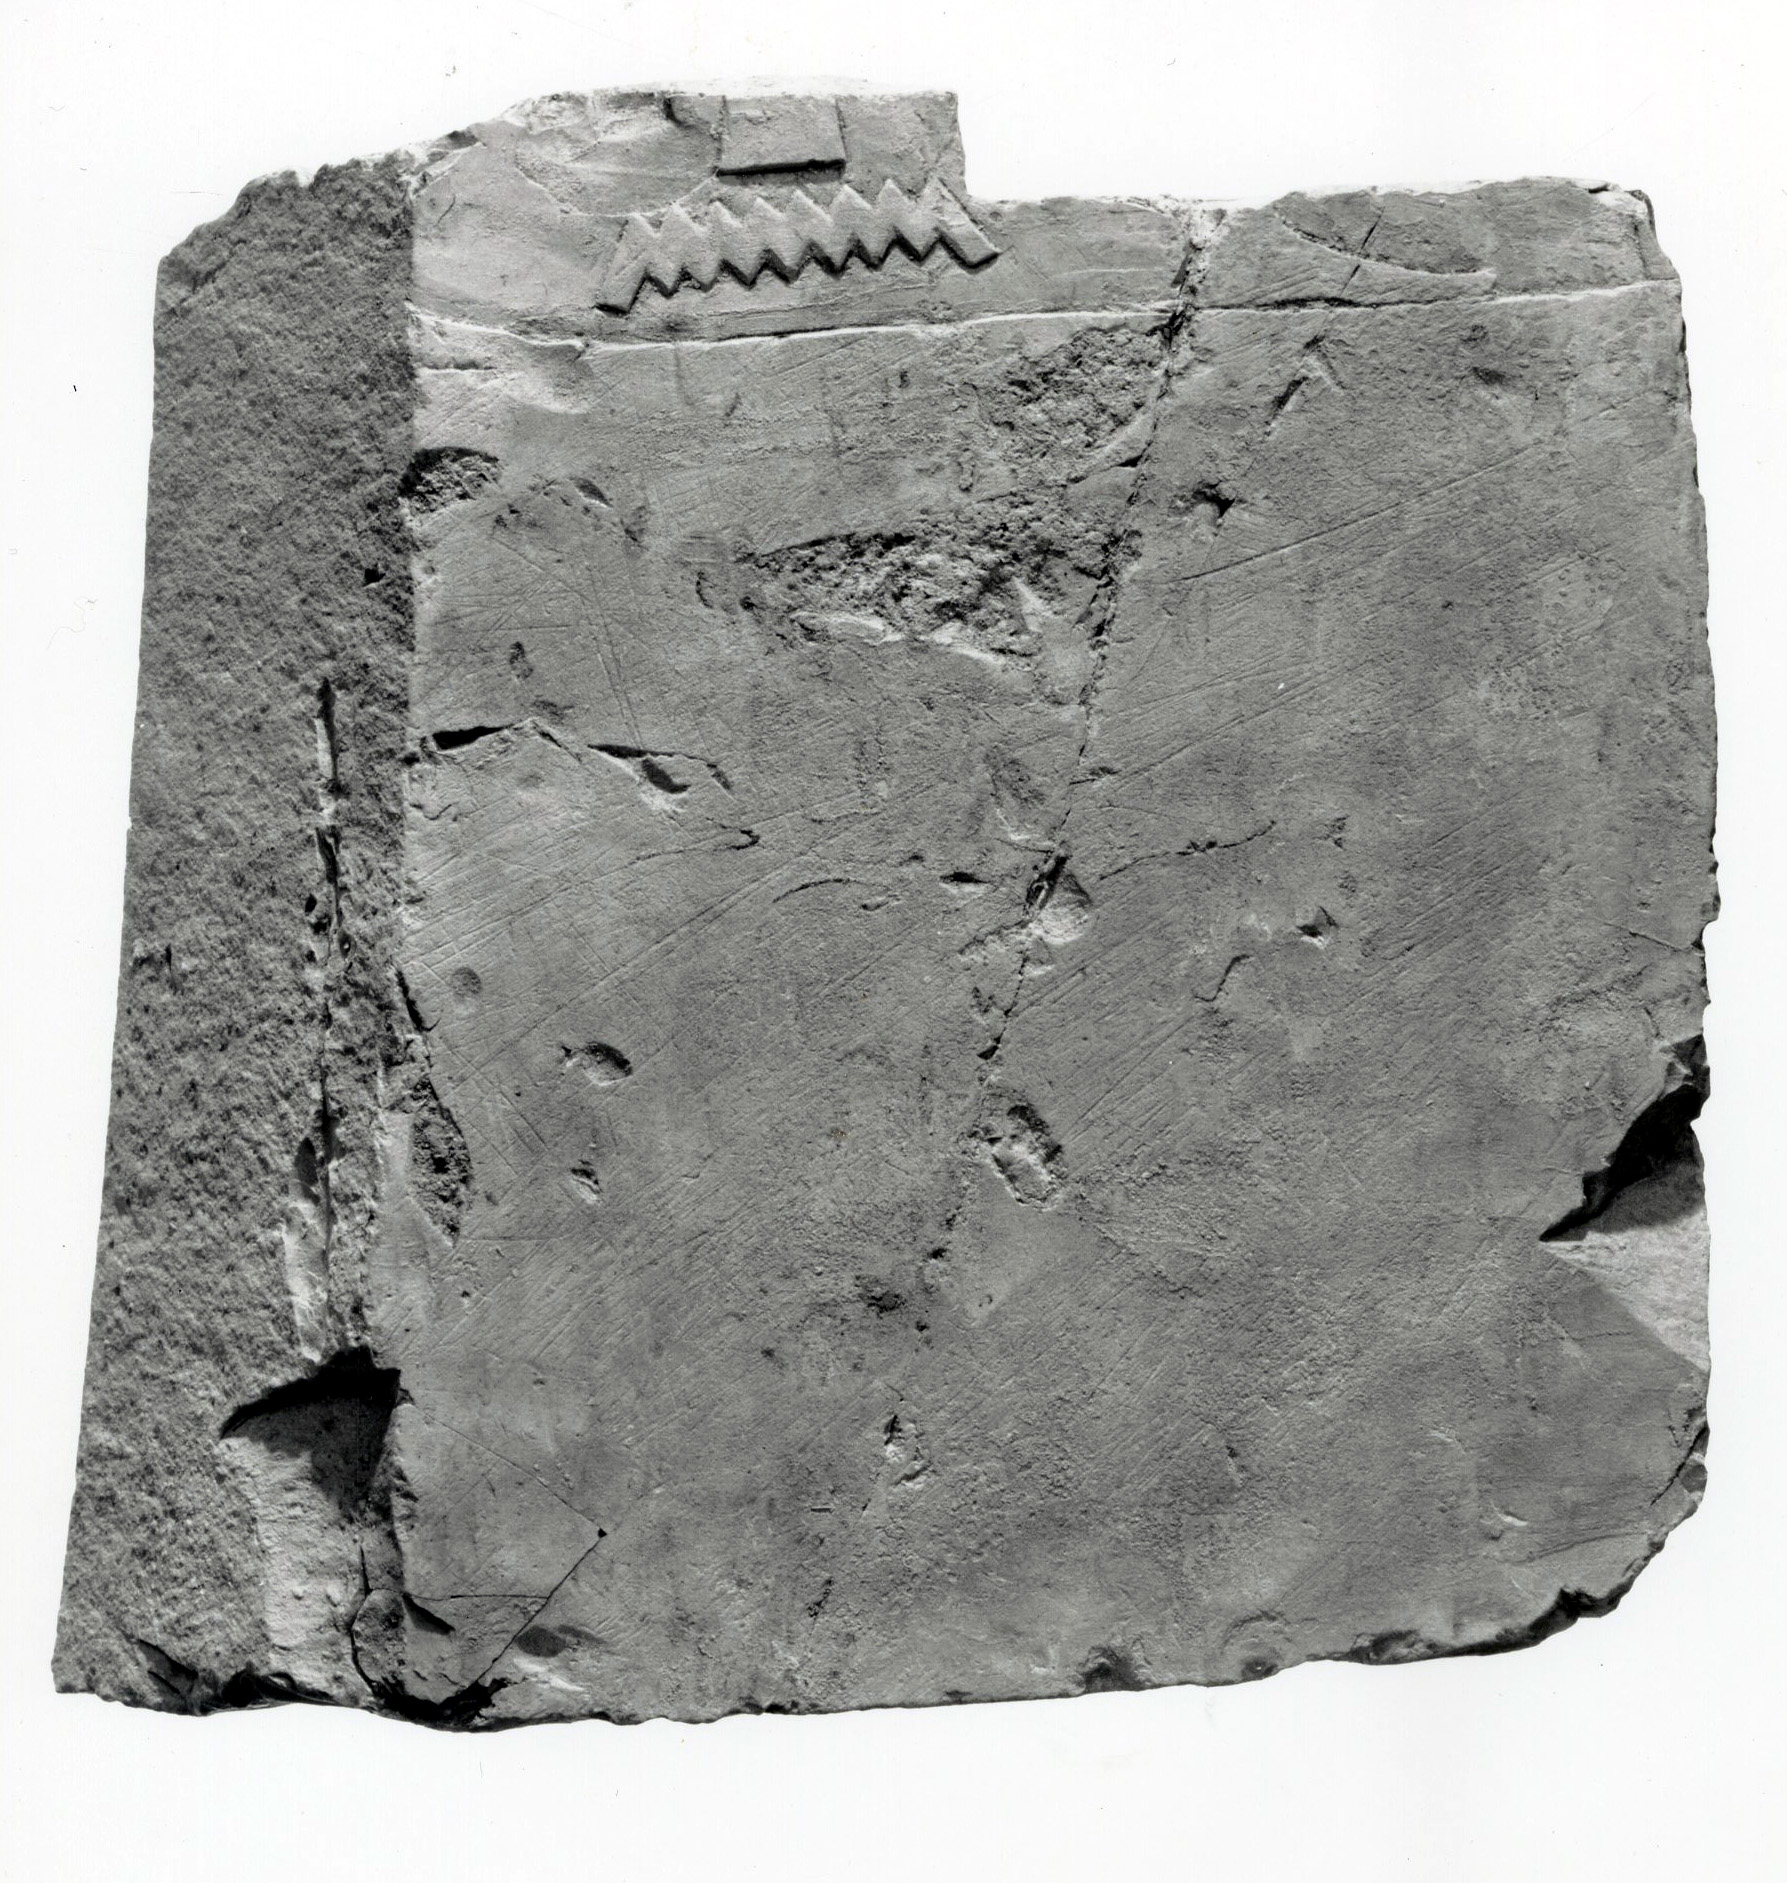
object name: relief, tomb of nespekashuty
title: Raised relief fragment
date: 664-610 BCE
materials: limestone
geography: egypt